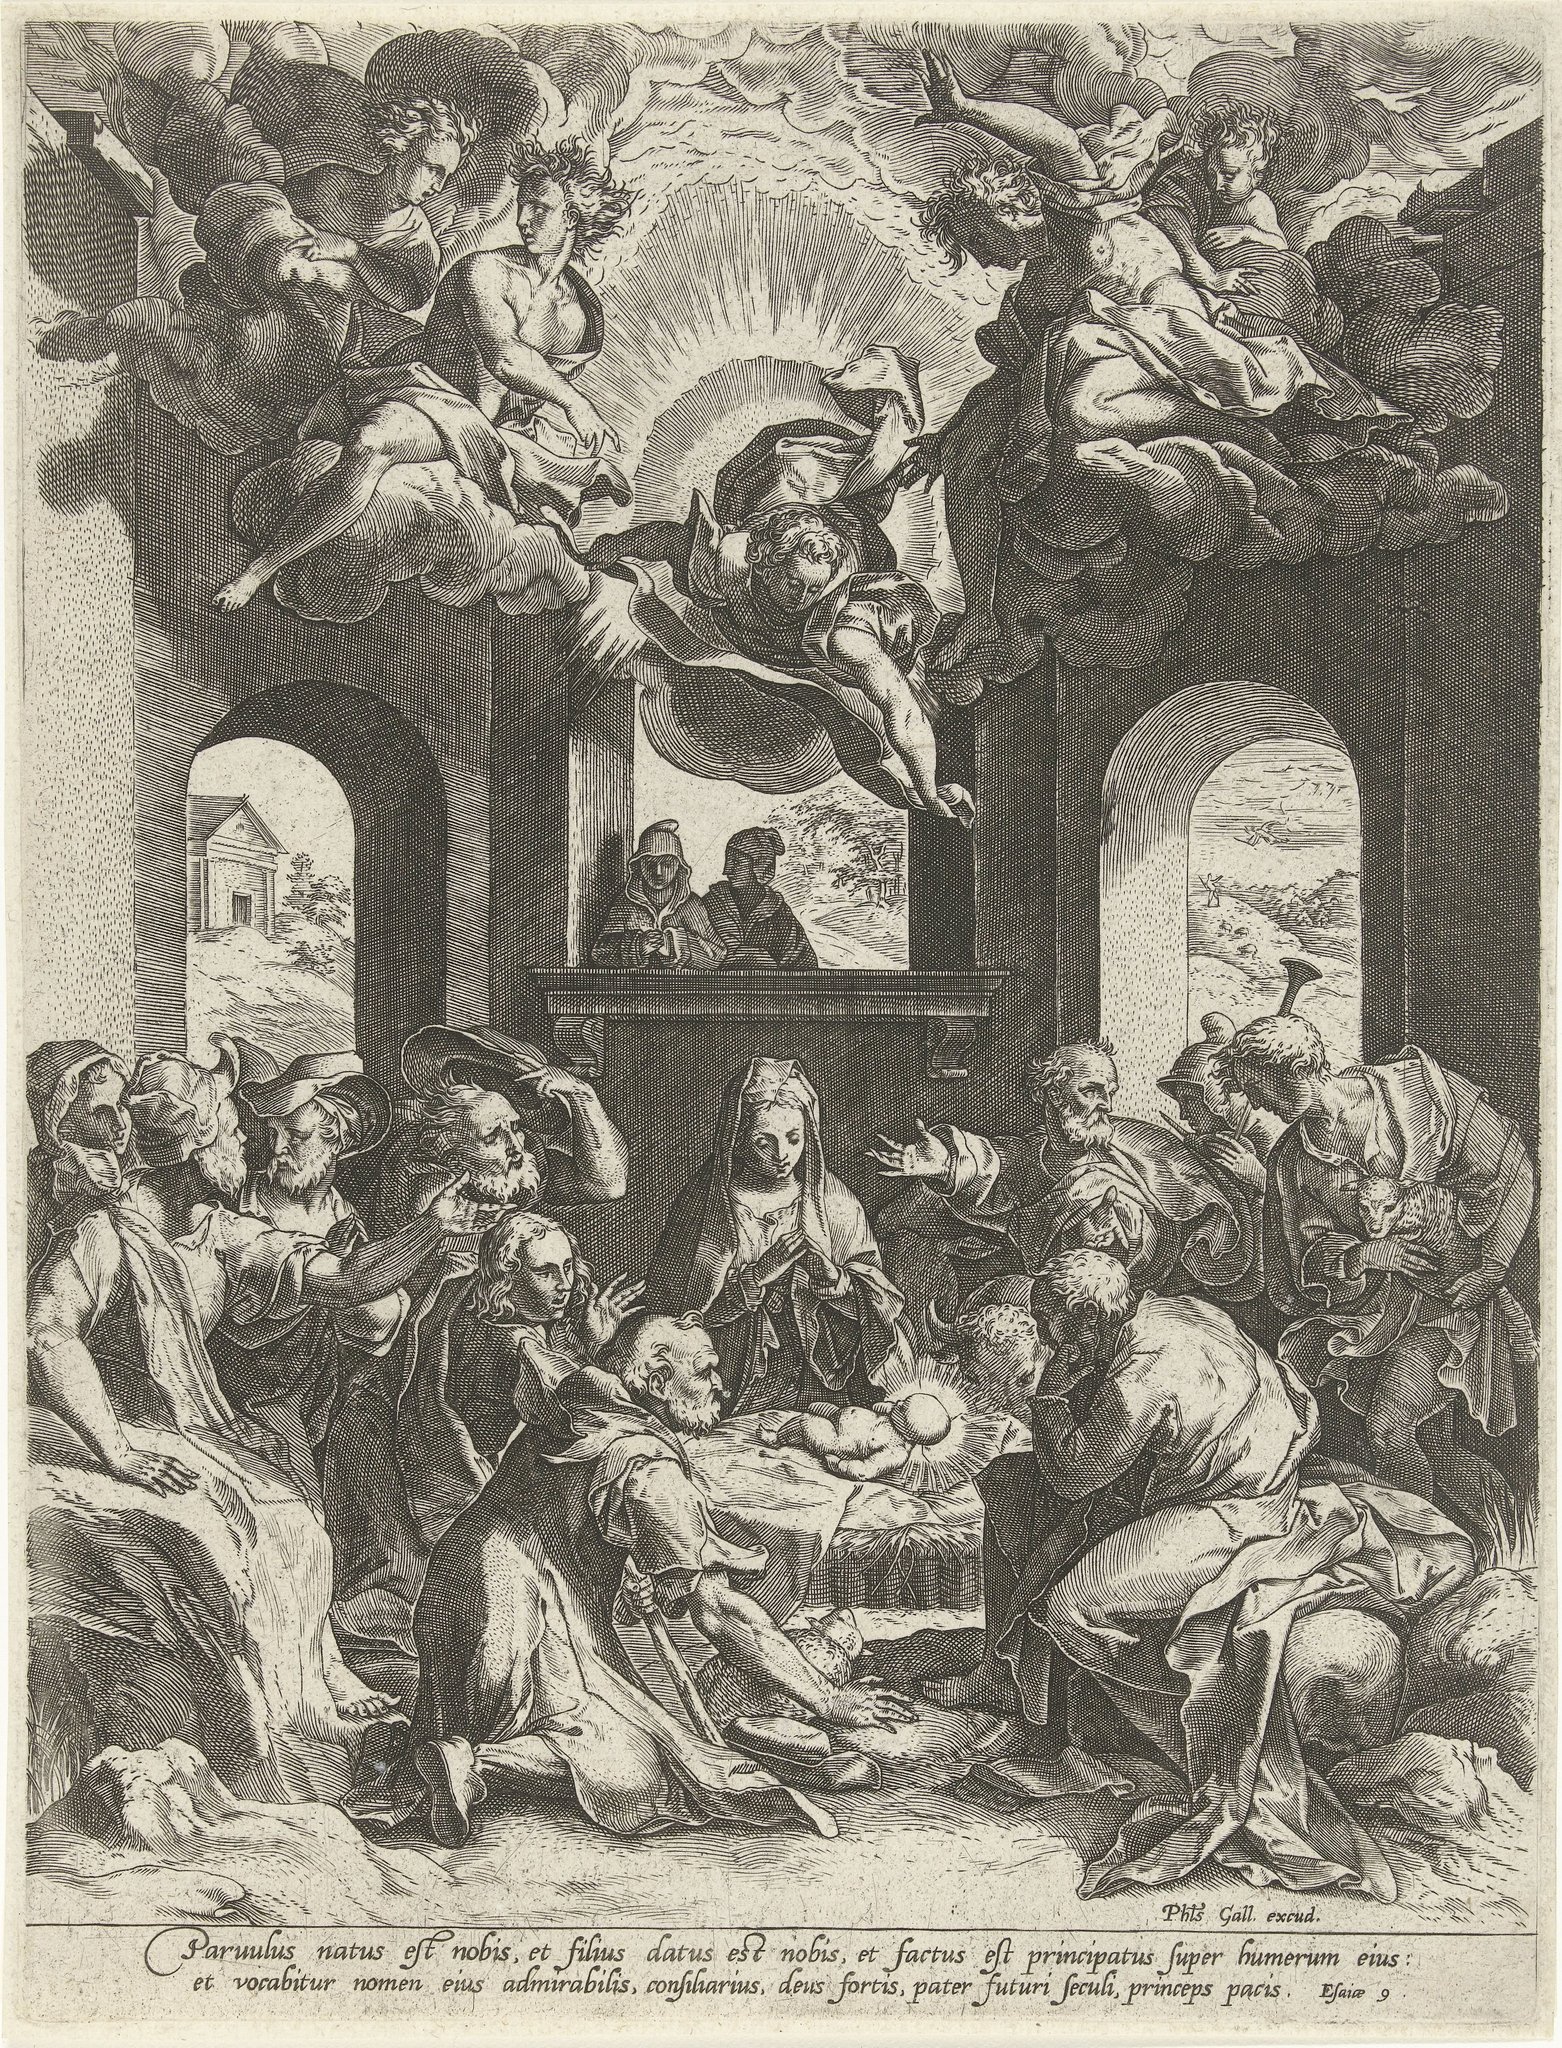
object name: print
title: Aanbidding door de herders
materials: paper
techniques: engraving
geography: antwerp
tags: adoration of the christ-child by the shepherds; mary and joseph present, isaiah's prophecy of the birth of christ ('immanuel') (possibly with mary, the angel gabriel and king ahaz) (isaiah 7:14-16)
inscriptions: caption: ‘Parvulus natus est ... seculi , princeps pacis.Esaiae 9’, address: ‘Phls Galle excud.’, collector's mark: Lugt 2228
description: In een ruimte met boogvormige ingangen zit Maria, in het midden, naar rechts gekeerd, geknield voor het Kind. Eromheen een grote groep herders. Boven hen een engel met banderol in de handen, omgeven door andere engelen in een wolk. Twee vrouwen kijken toe door een open venster. Met onderschrift uit Jesaja 9 waarin de geboorte van Christus wordt aangekondigd.